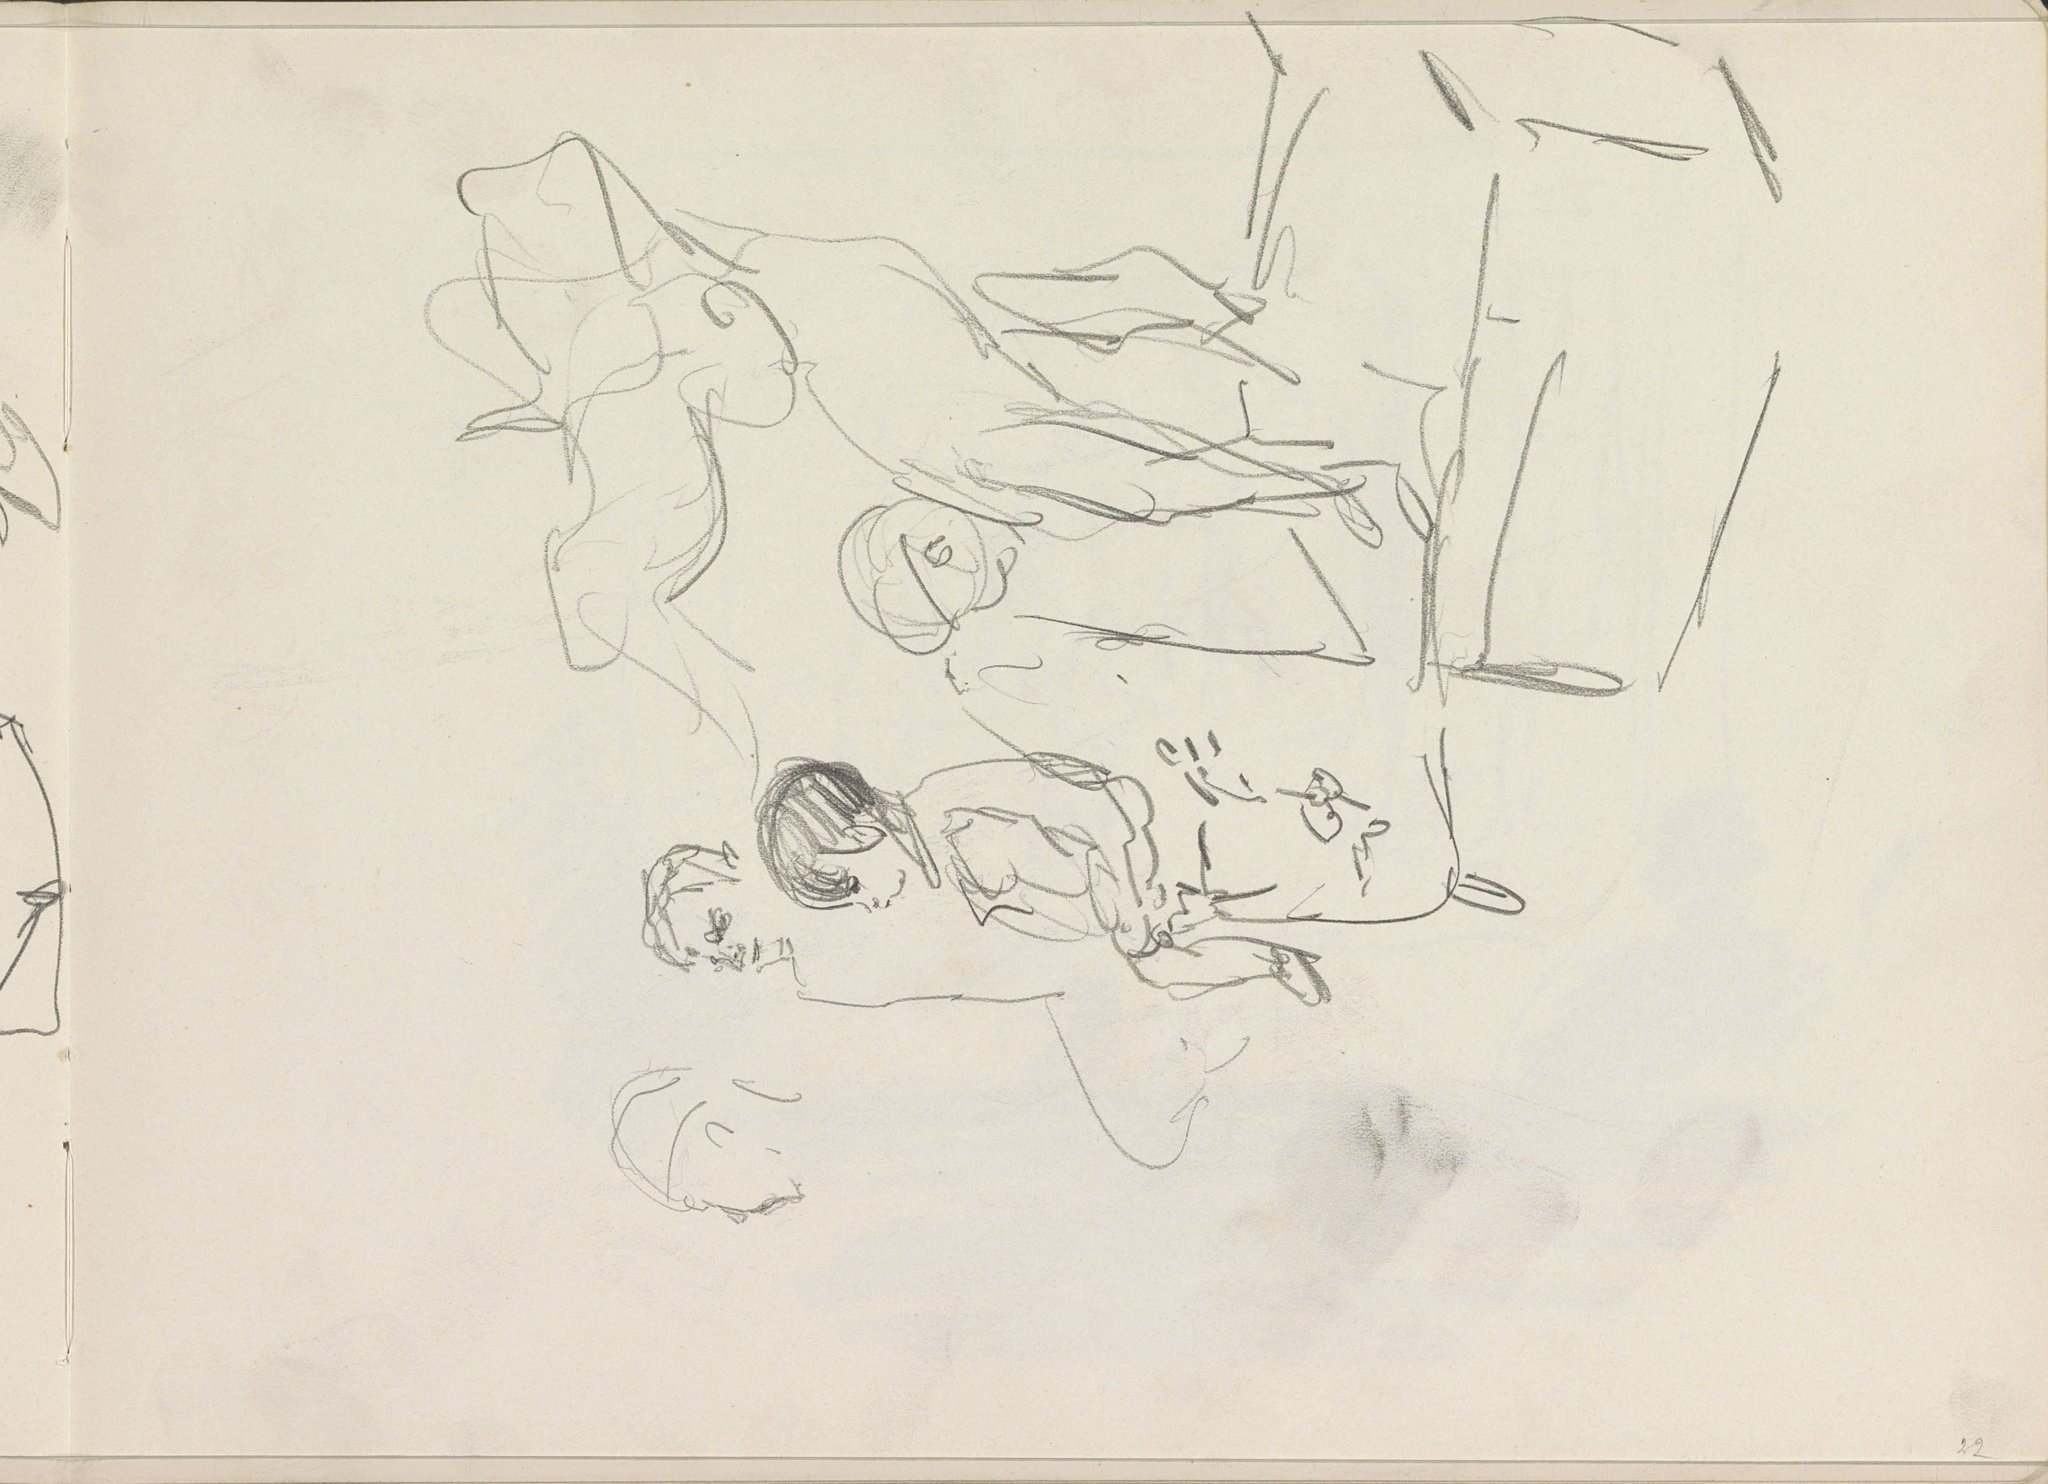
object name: sketchbook leaf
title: Figuurstudies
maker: isaac israels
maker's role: draughtsman, painter, print maker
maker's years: 1865-1934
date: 1875-1934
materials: paper, pencil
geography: the hague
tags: boy (child between toddler and youth) (+ sitting), acrobat ~ circus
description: Onder andere een zittende jongen en een acrobaat die op zijn handen staat. Blad 22 recto uit schetsboek V met 33 bladen.